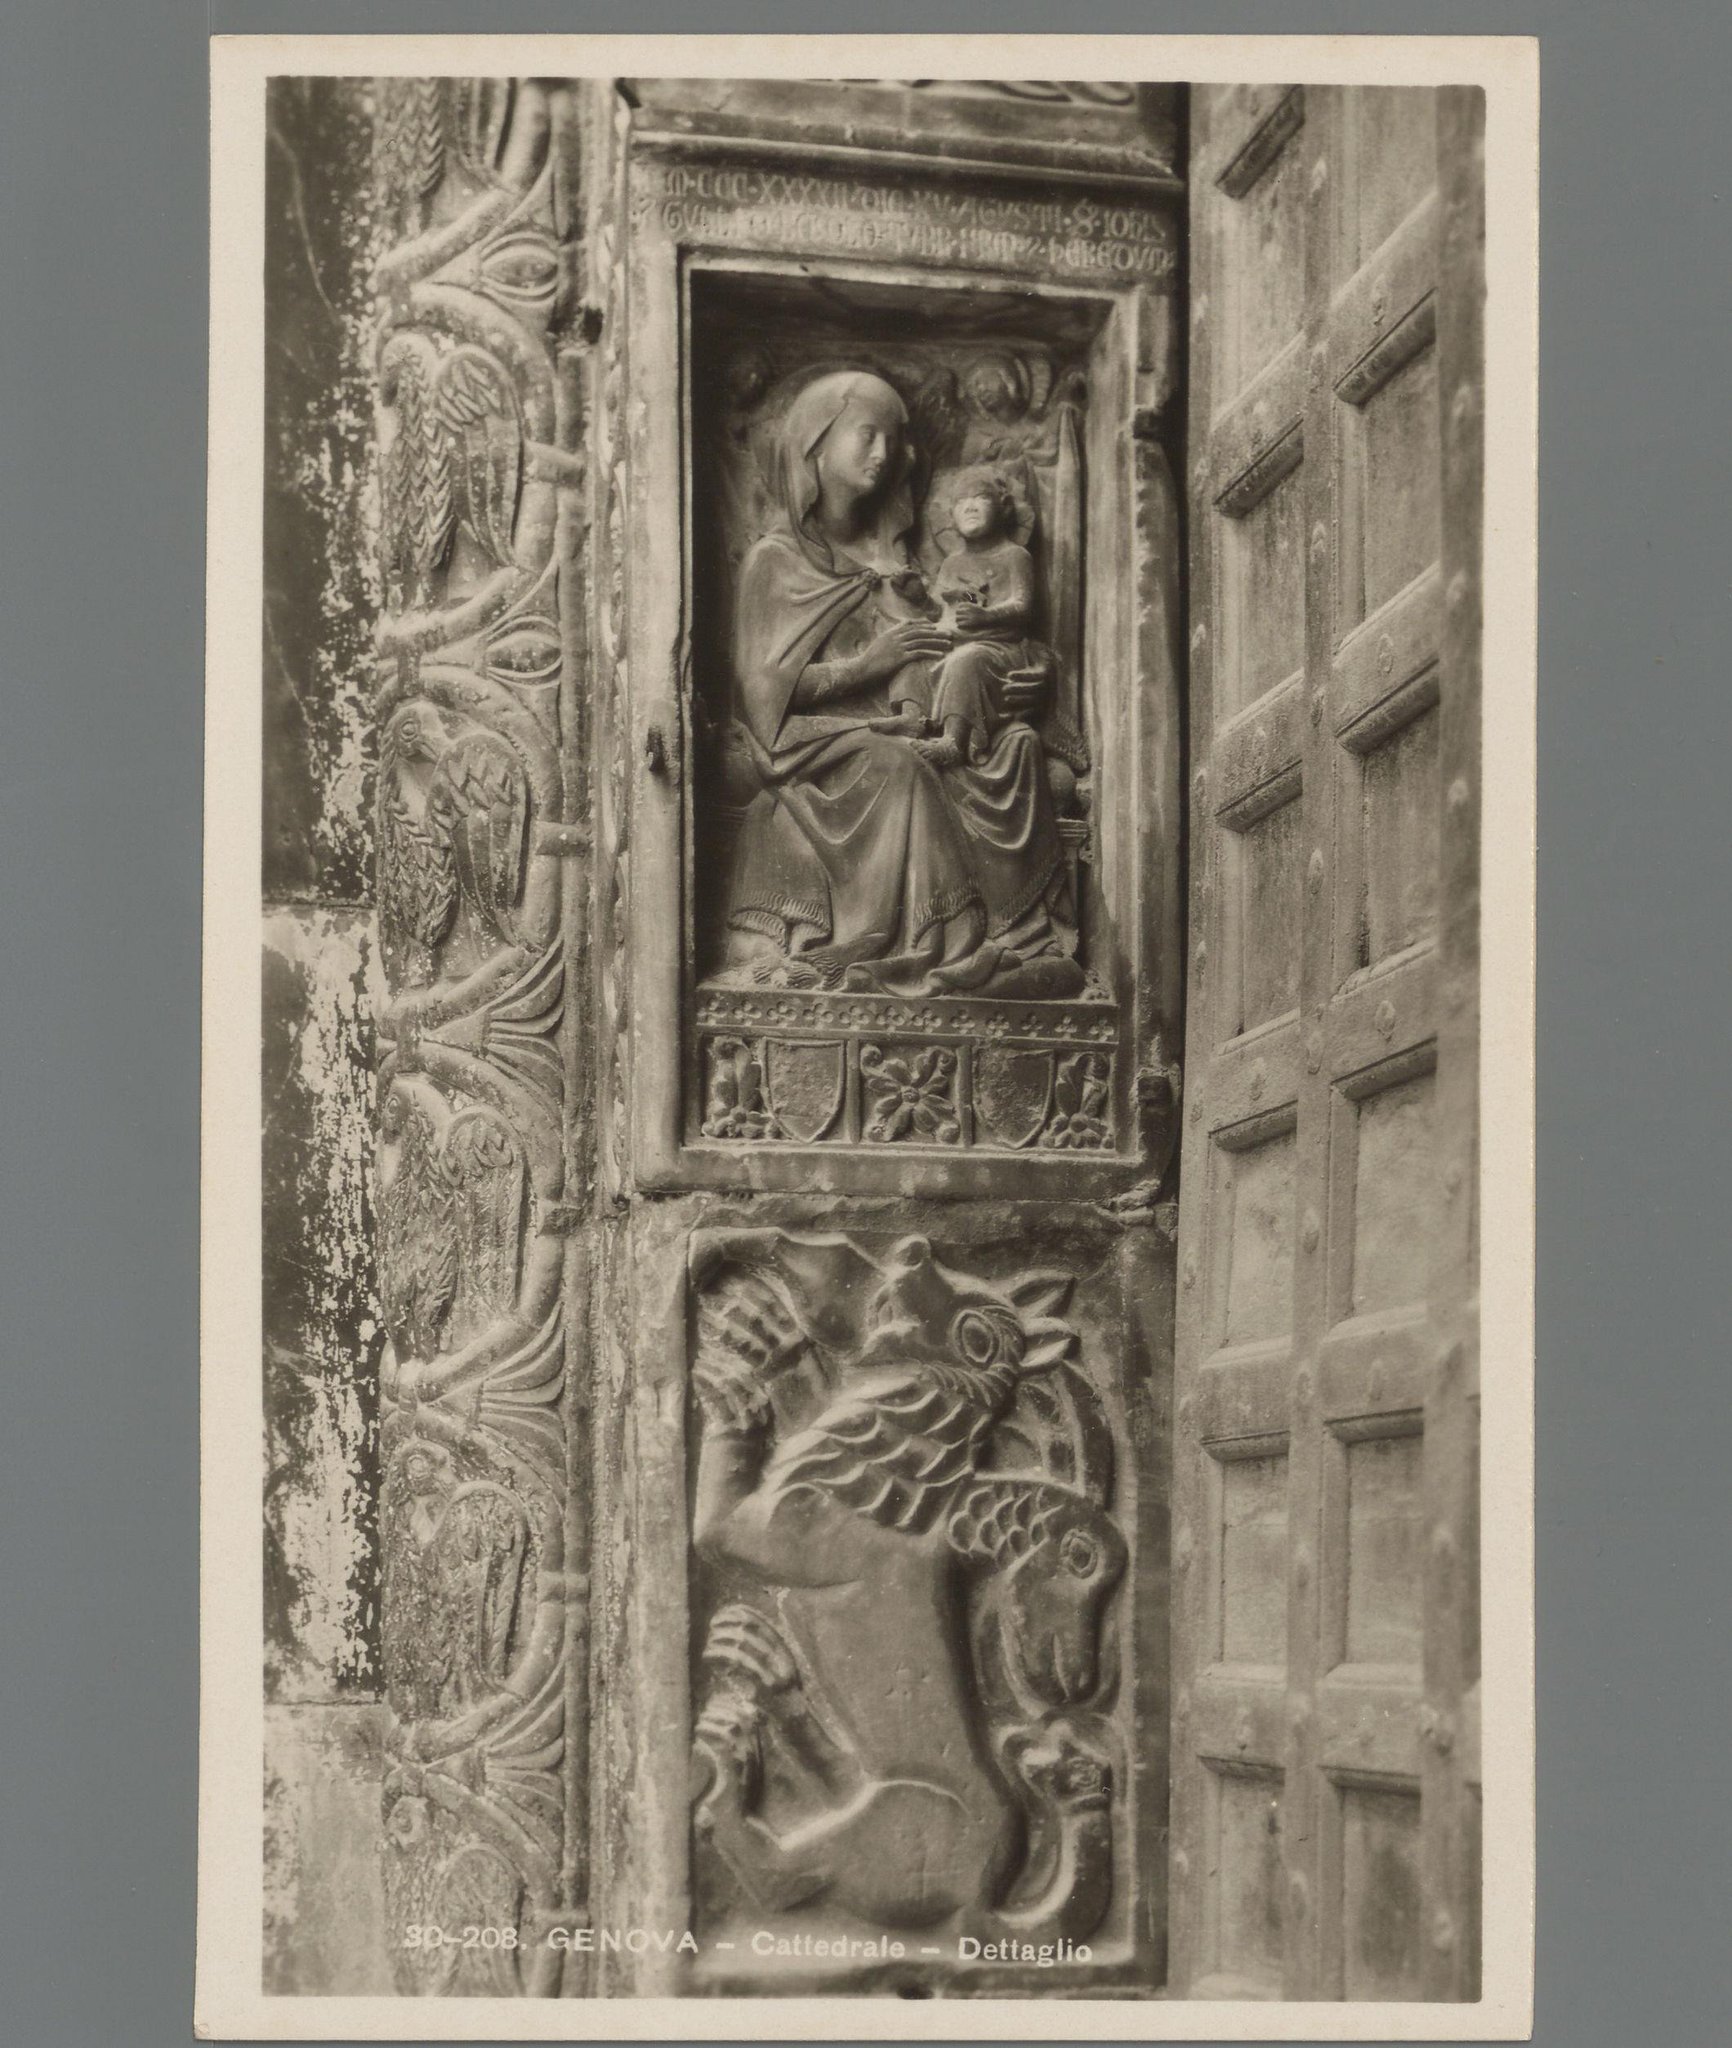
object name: ansichtkaart, prentbriefkaart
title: Genova. Cattedrale. Dettaglio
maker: Anonymous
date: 1904-1935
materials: photographic support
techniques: photography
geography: como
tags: interior of church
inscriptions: collector's mark: ‘AFE v S’